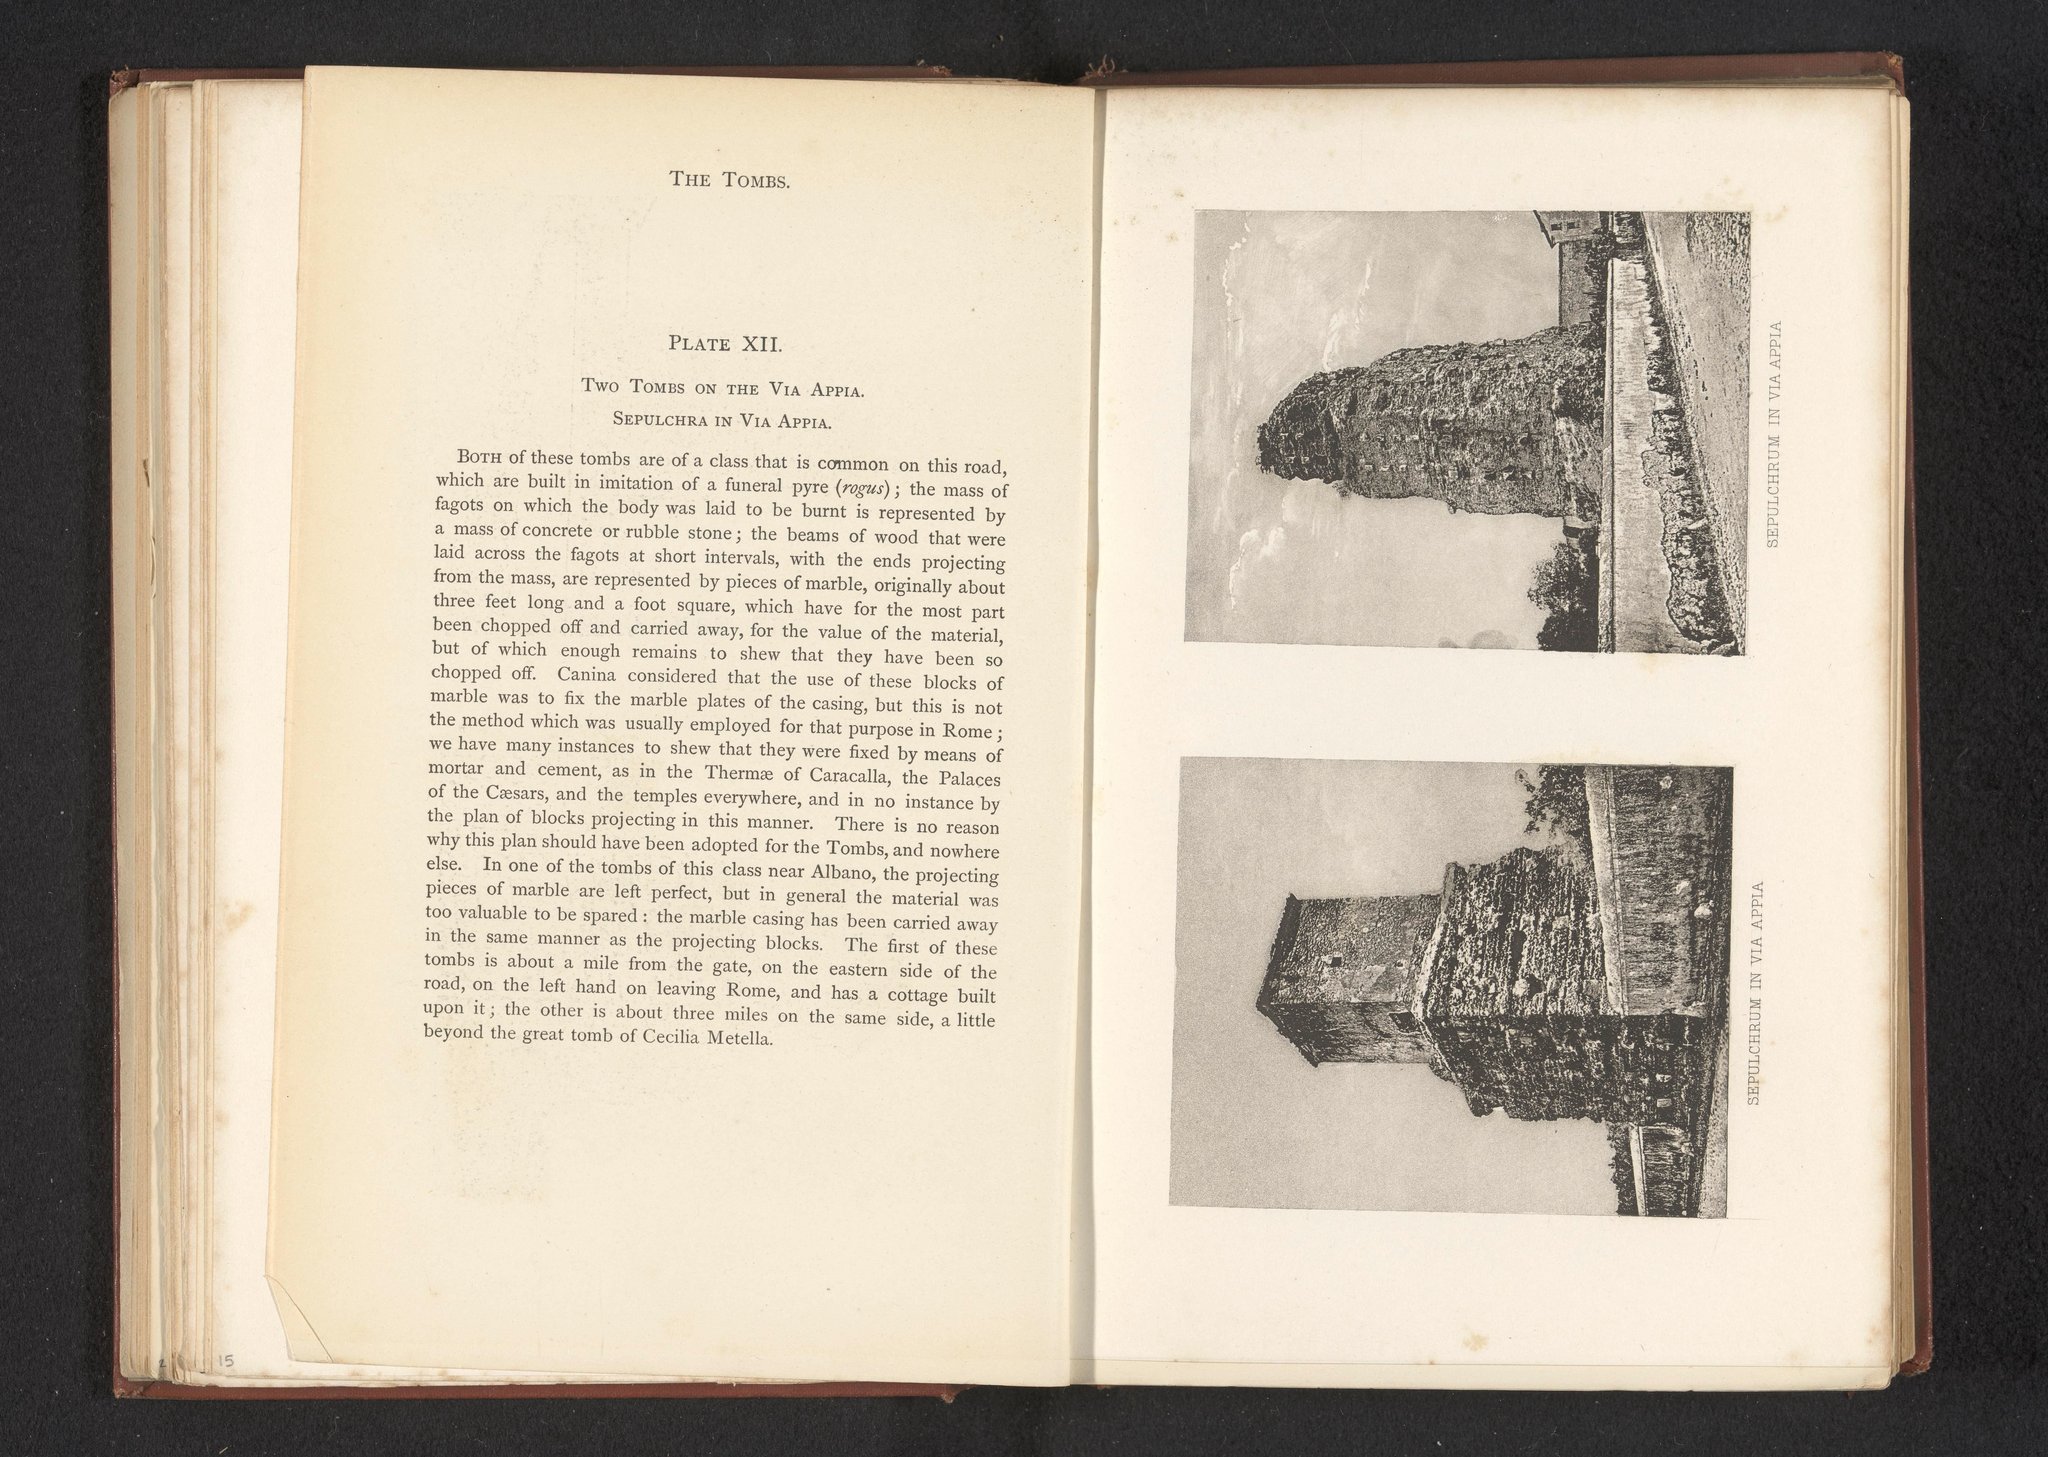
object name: page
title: Twee tombes op de Via Appia in Rome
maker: Anonymous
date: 1867-1877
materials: paper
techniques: photoaquatint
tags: grave, tomb